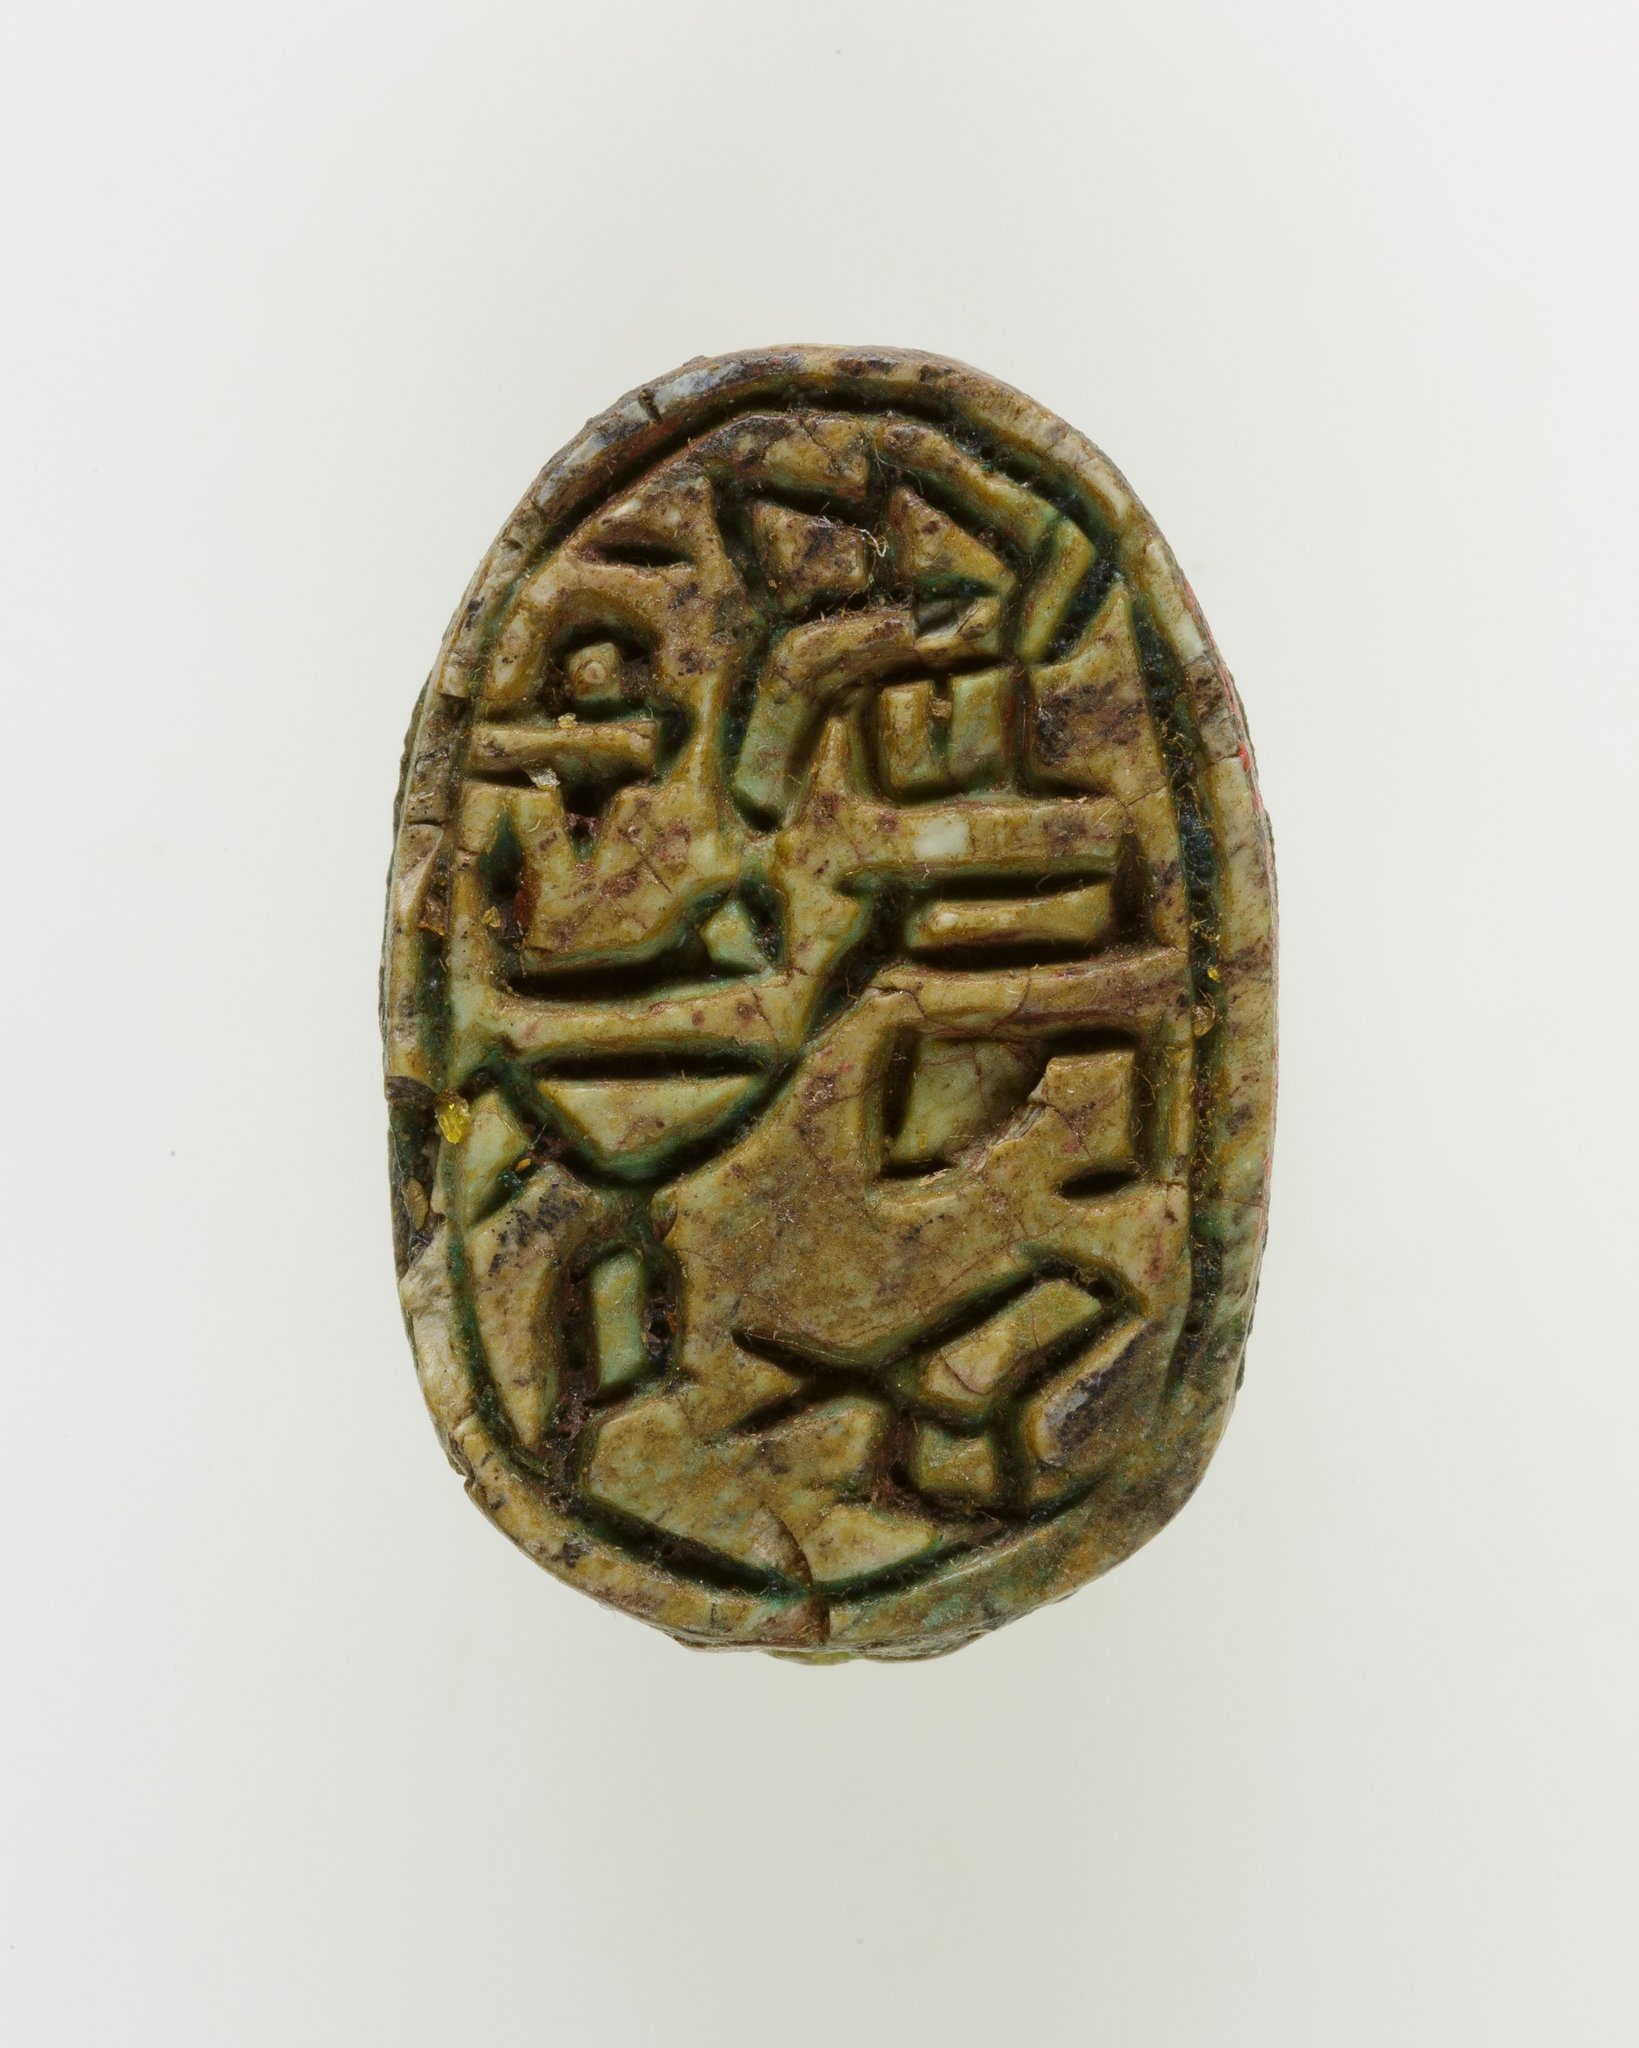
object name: scarab, official, private name and title, iti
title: Scarab of an Official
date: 1760-1670 BCE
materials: stone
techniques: glazing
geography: egypt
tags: hieroglyphs,scarabs